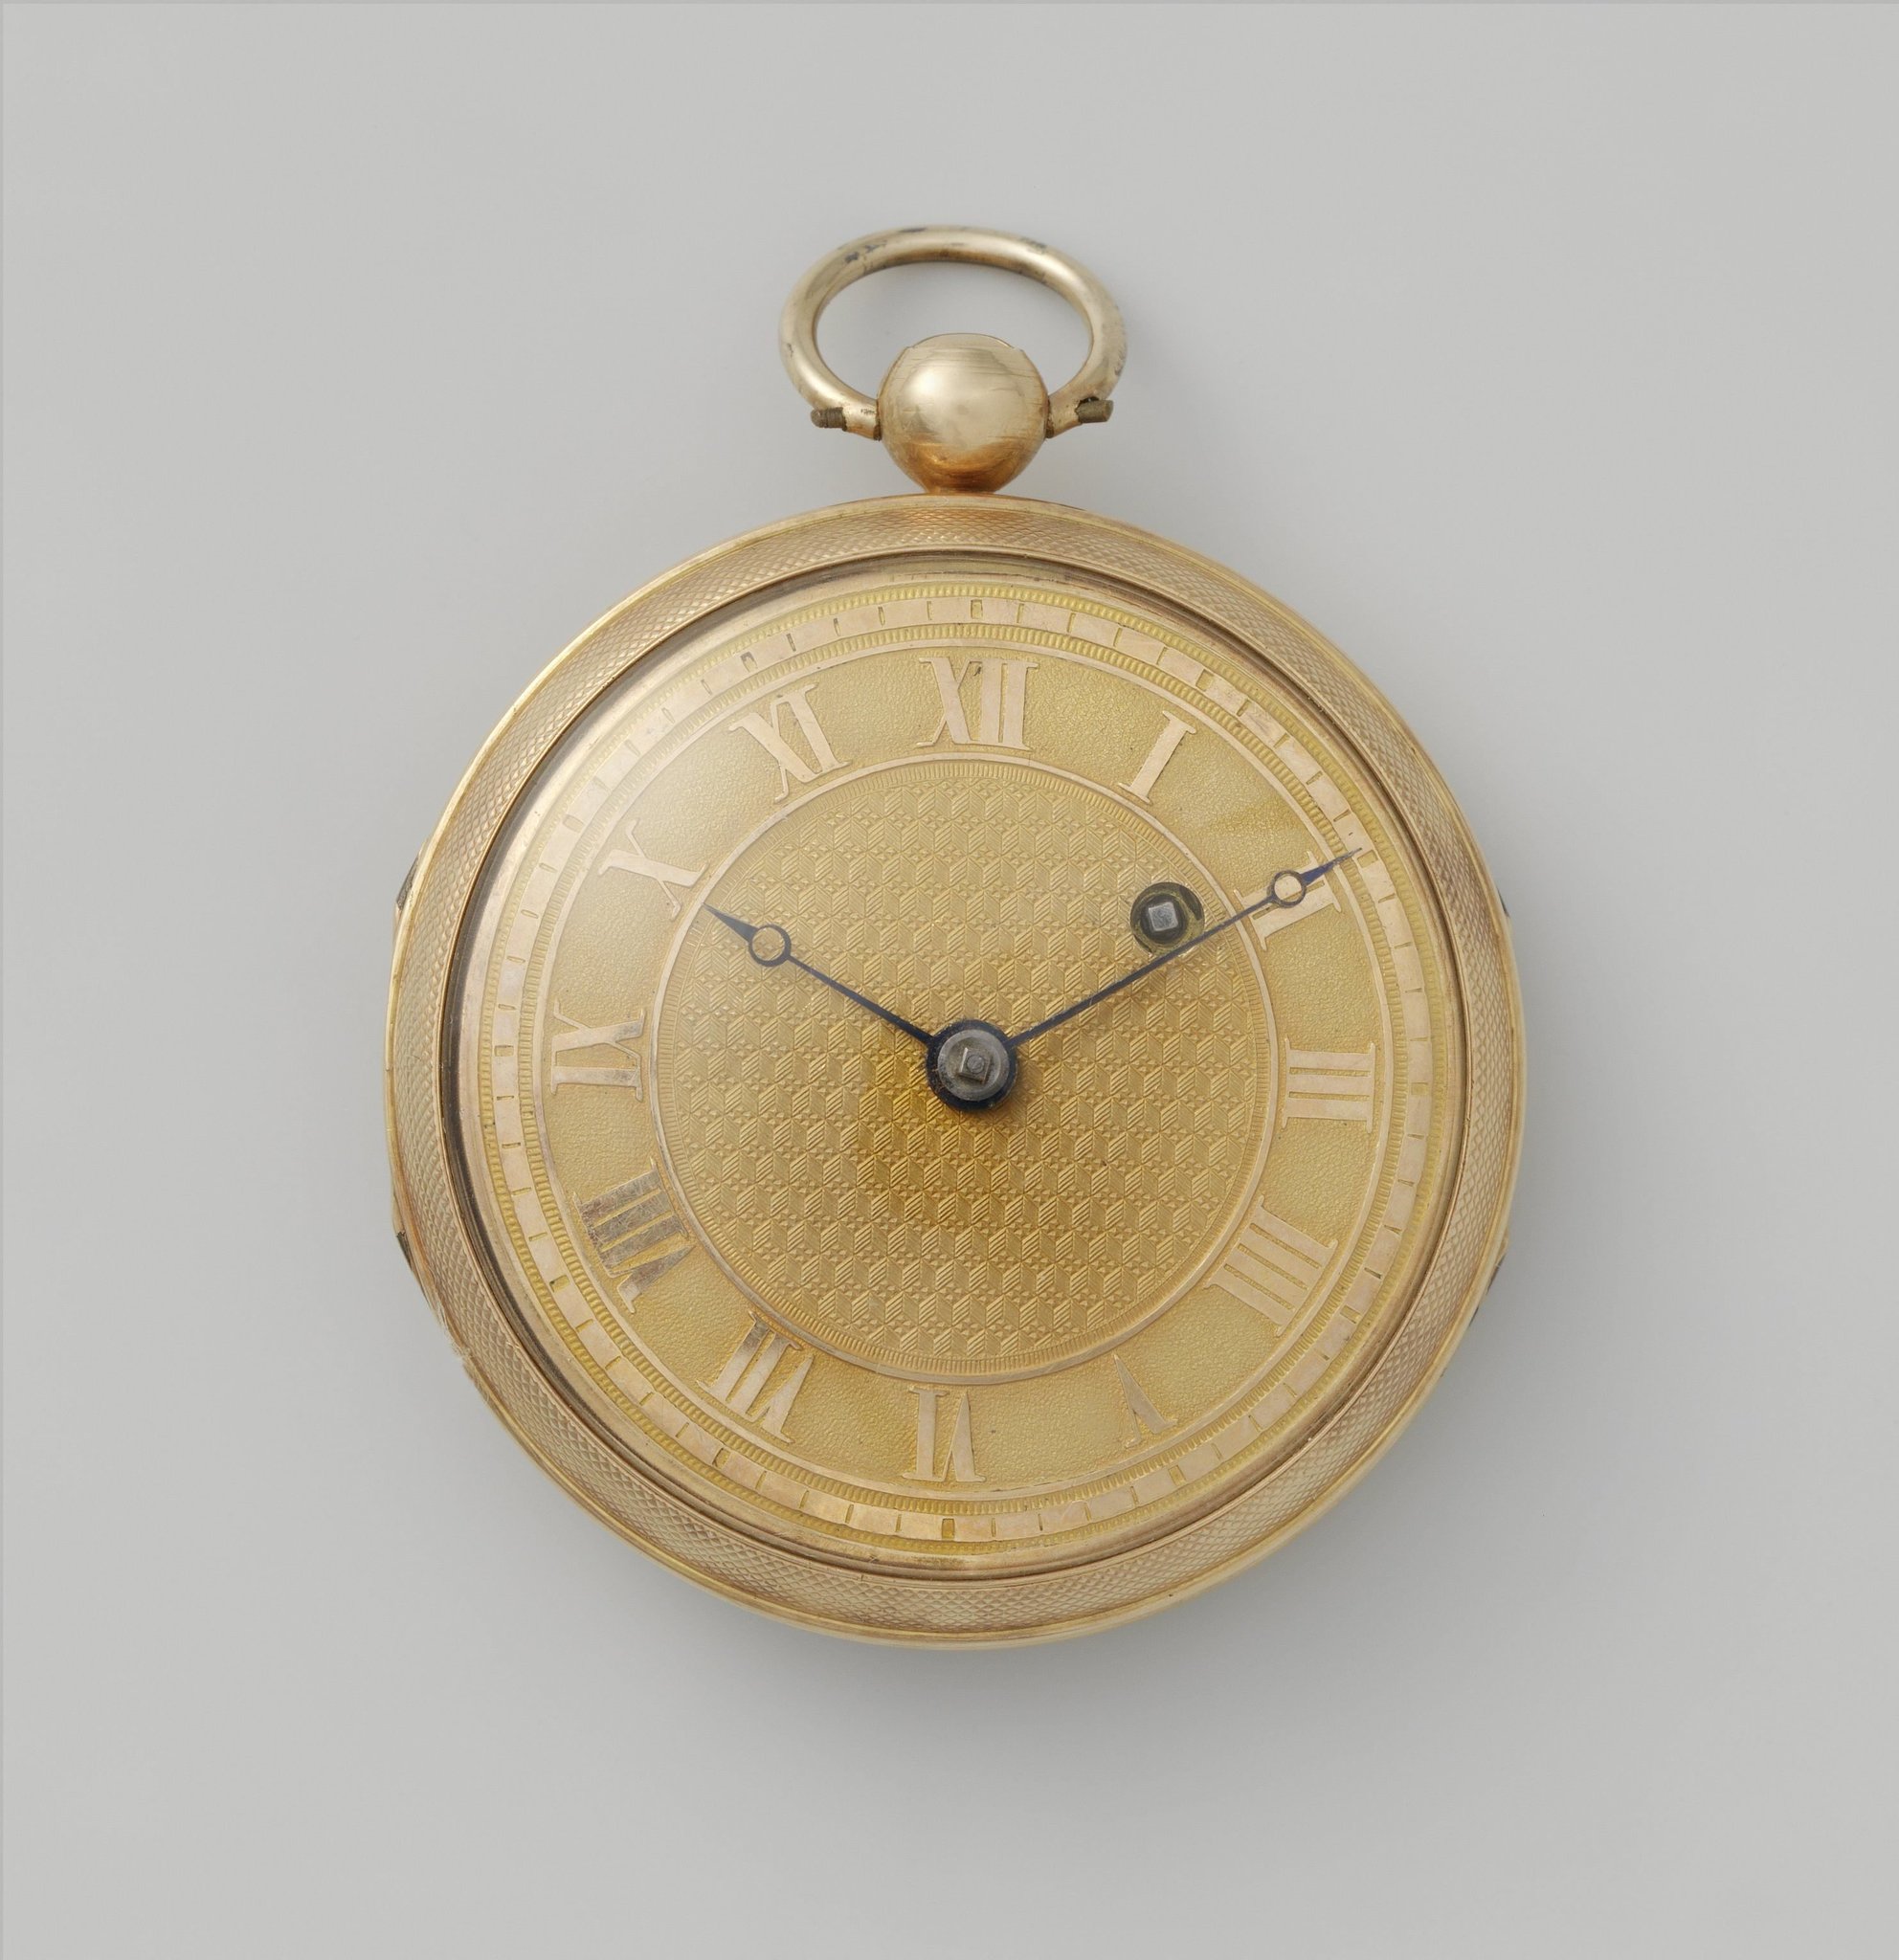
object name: wrist watch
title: Watch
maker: Anonymous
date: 1825-1875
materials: glass, gold, gemstone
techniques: engraving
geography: switzerland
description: Gouden horloge met een gegraveerde wijzerplaat. De dubbele achterbodem van de kast is onder het glas versierd met geciseleerd bladwerk en robijnen.